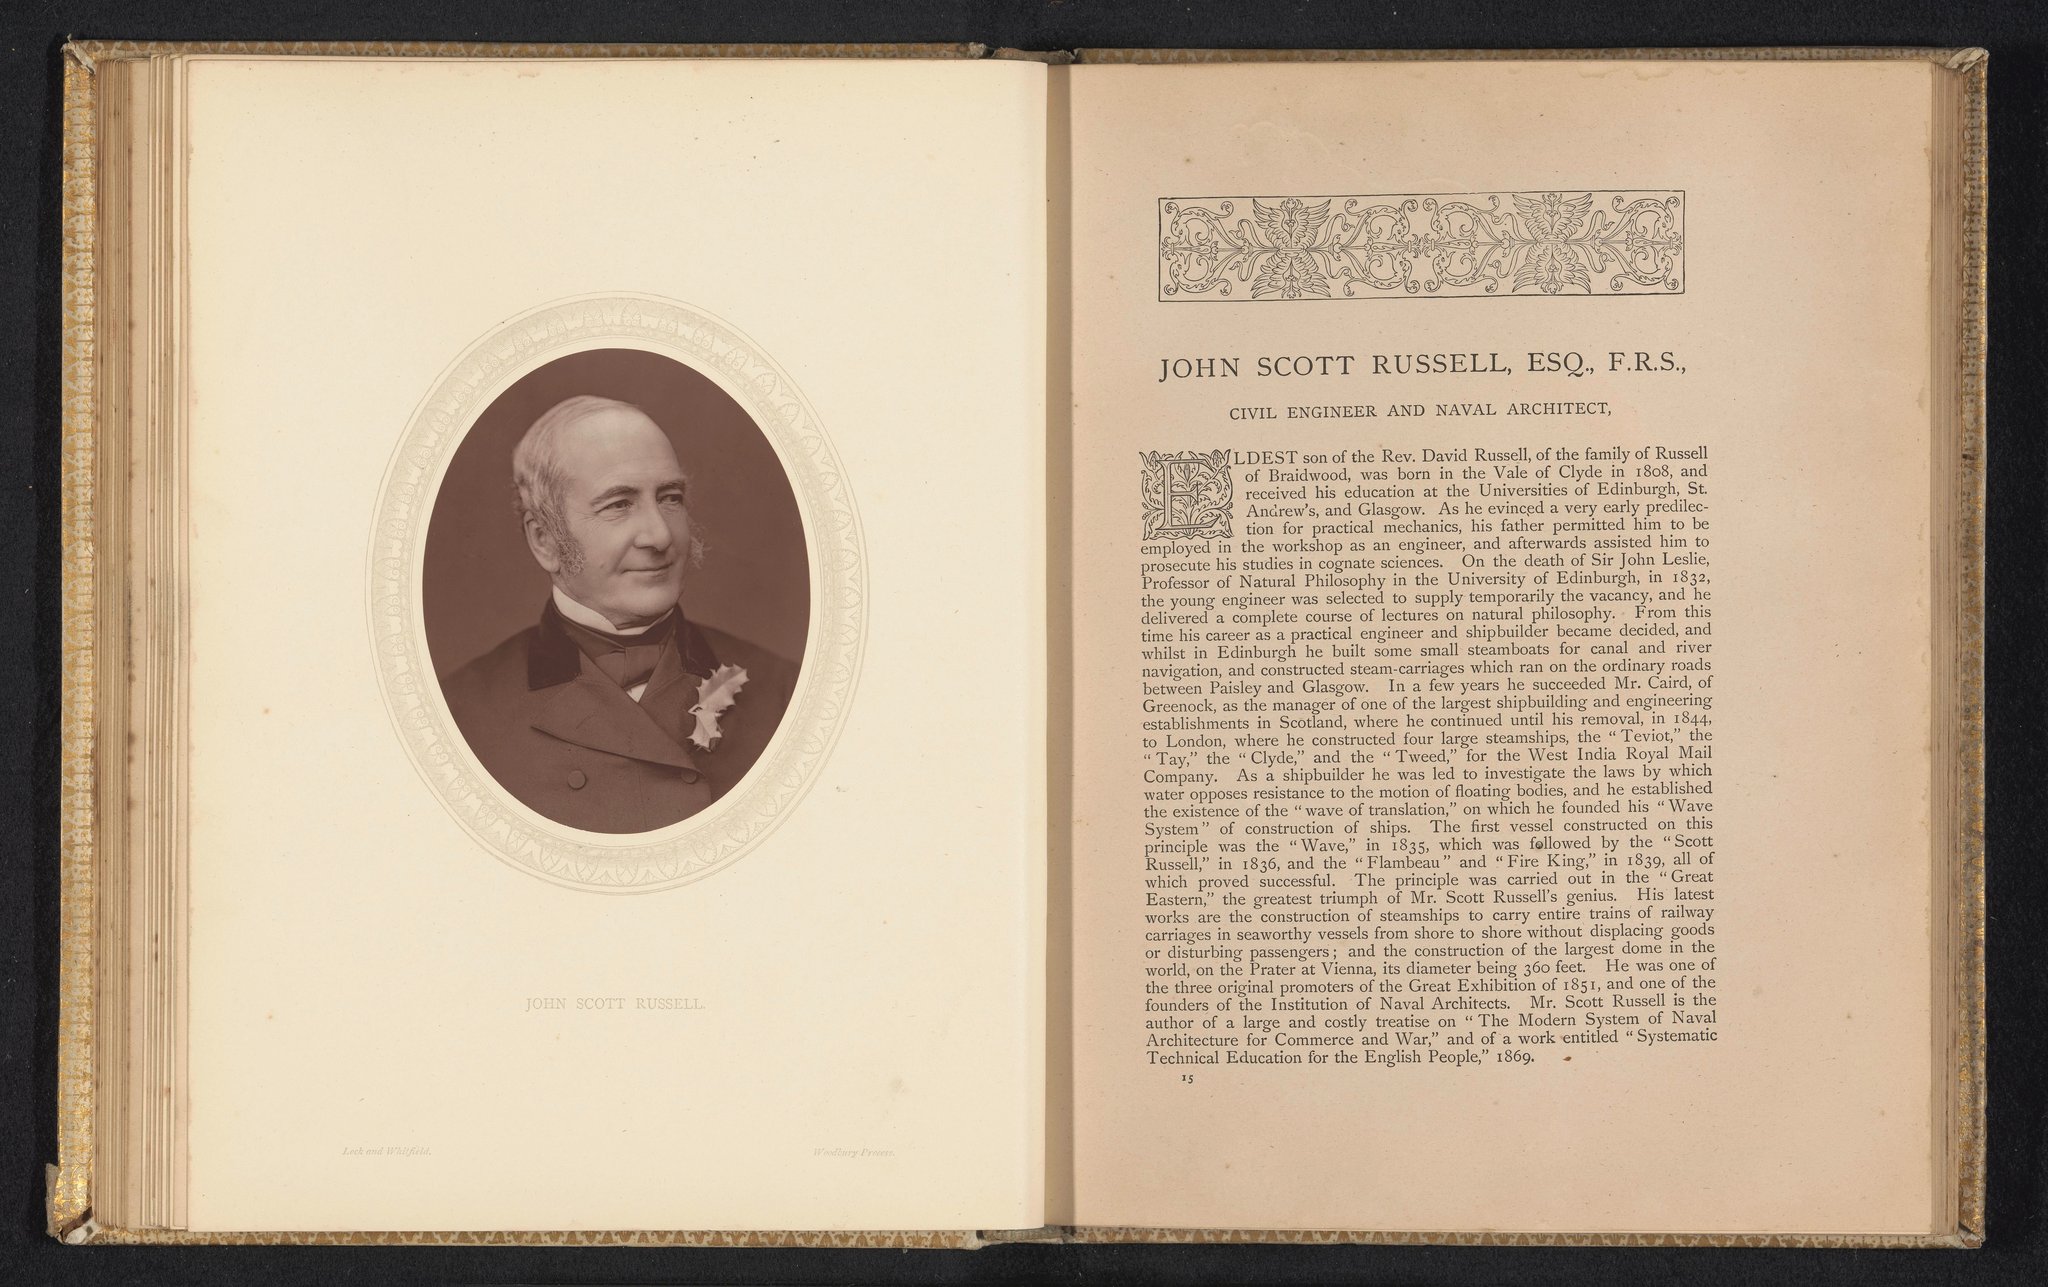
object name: page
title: John Scott Russell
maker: Anonymous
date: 1873-1878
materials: paper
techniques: woodburytype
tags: engineer, historical persons (portraits and scenes from the life) (+ (full) bust portrait), shipbuilding industry